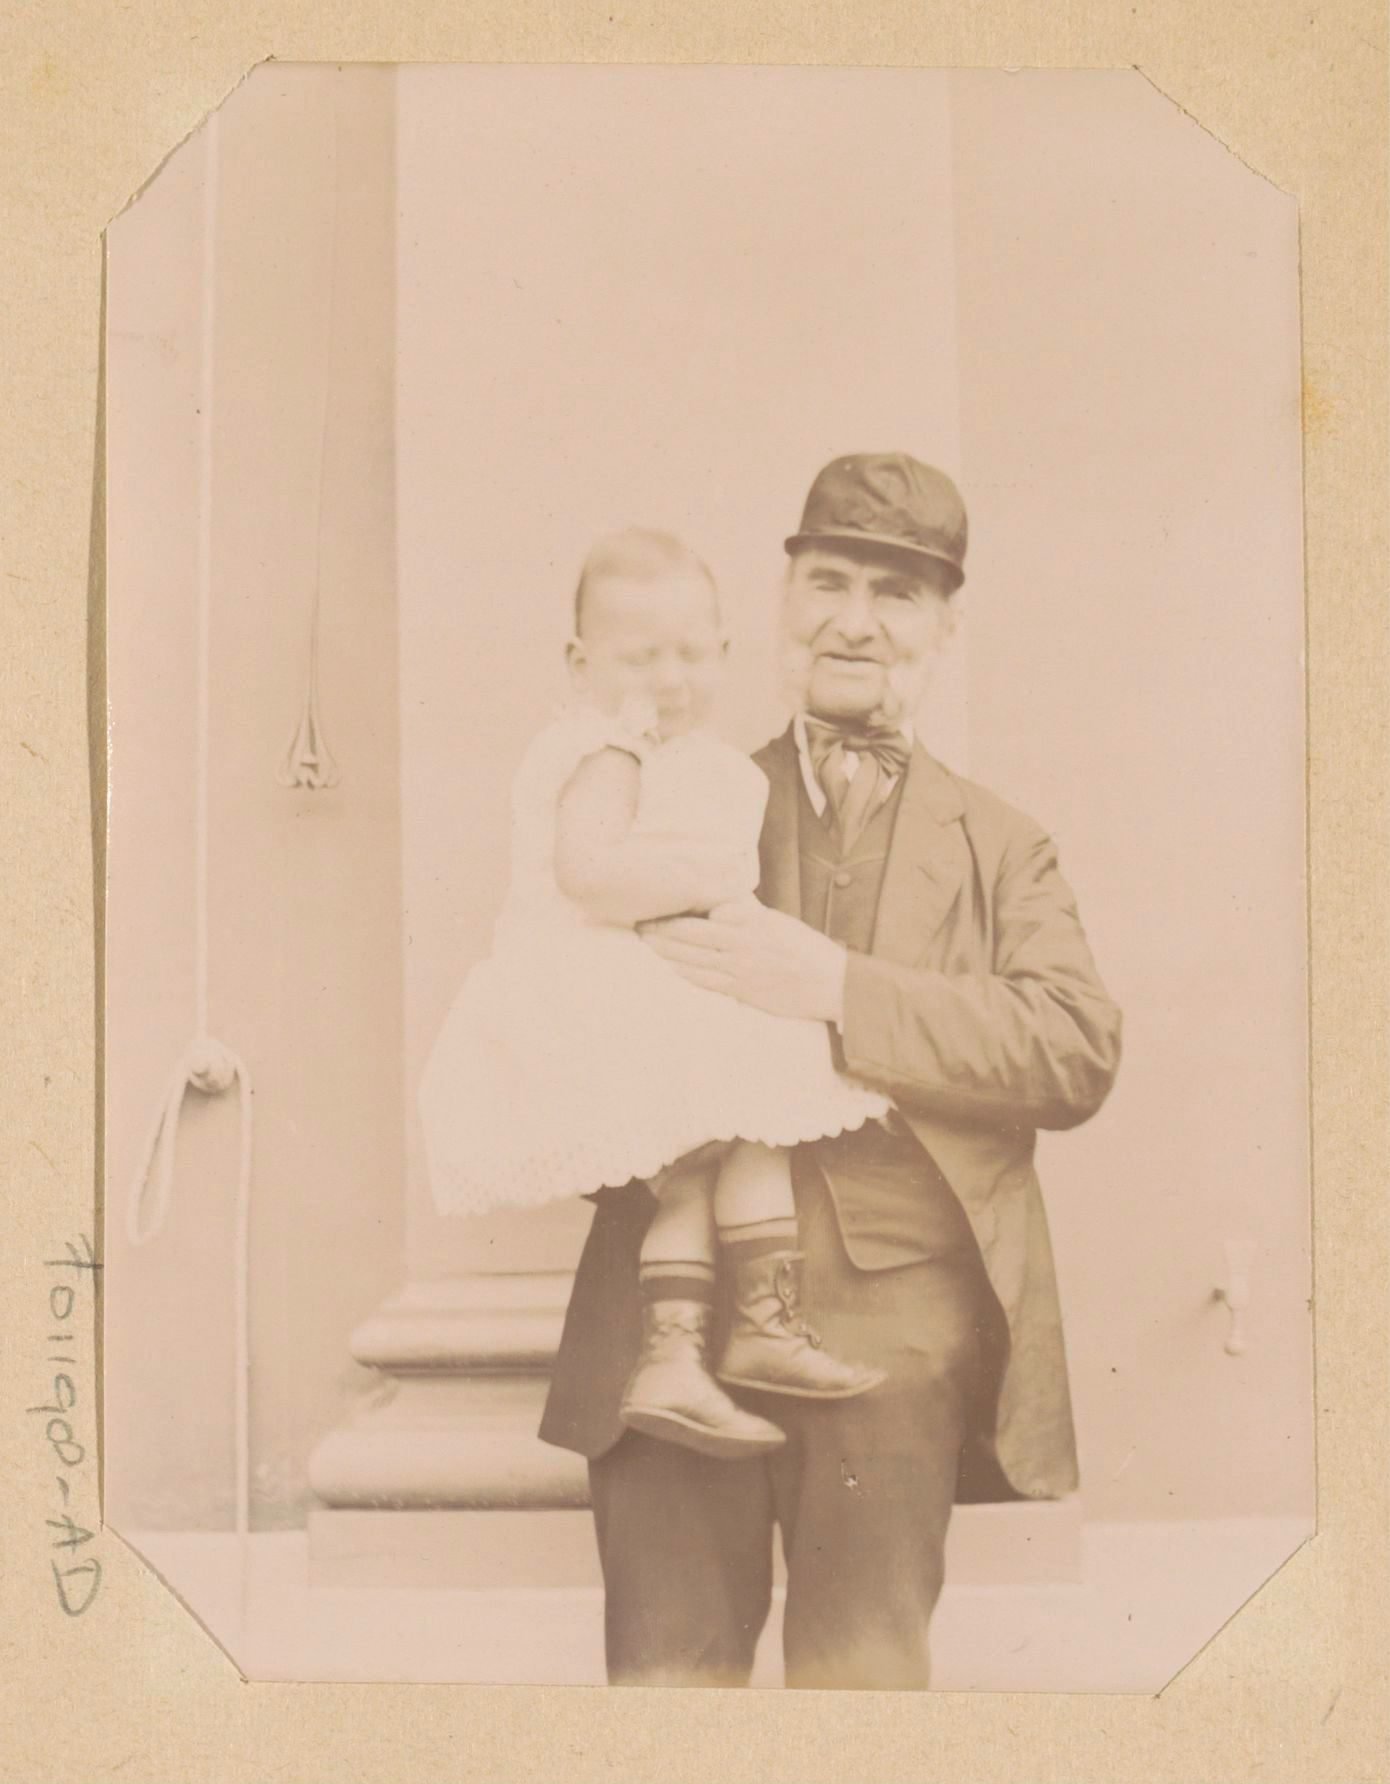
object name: album leaf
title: Portret van een onbekende oude man met peuter op de arm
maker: johanna margaretha piek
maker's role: fotograaf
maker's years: 1870-1947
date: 1889-1893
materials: paper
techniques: gelatin silver print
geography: netherlands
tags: toddler, old man, anonymous historical person portrayed, netherlands